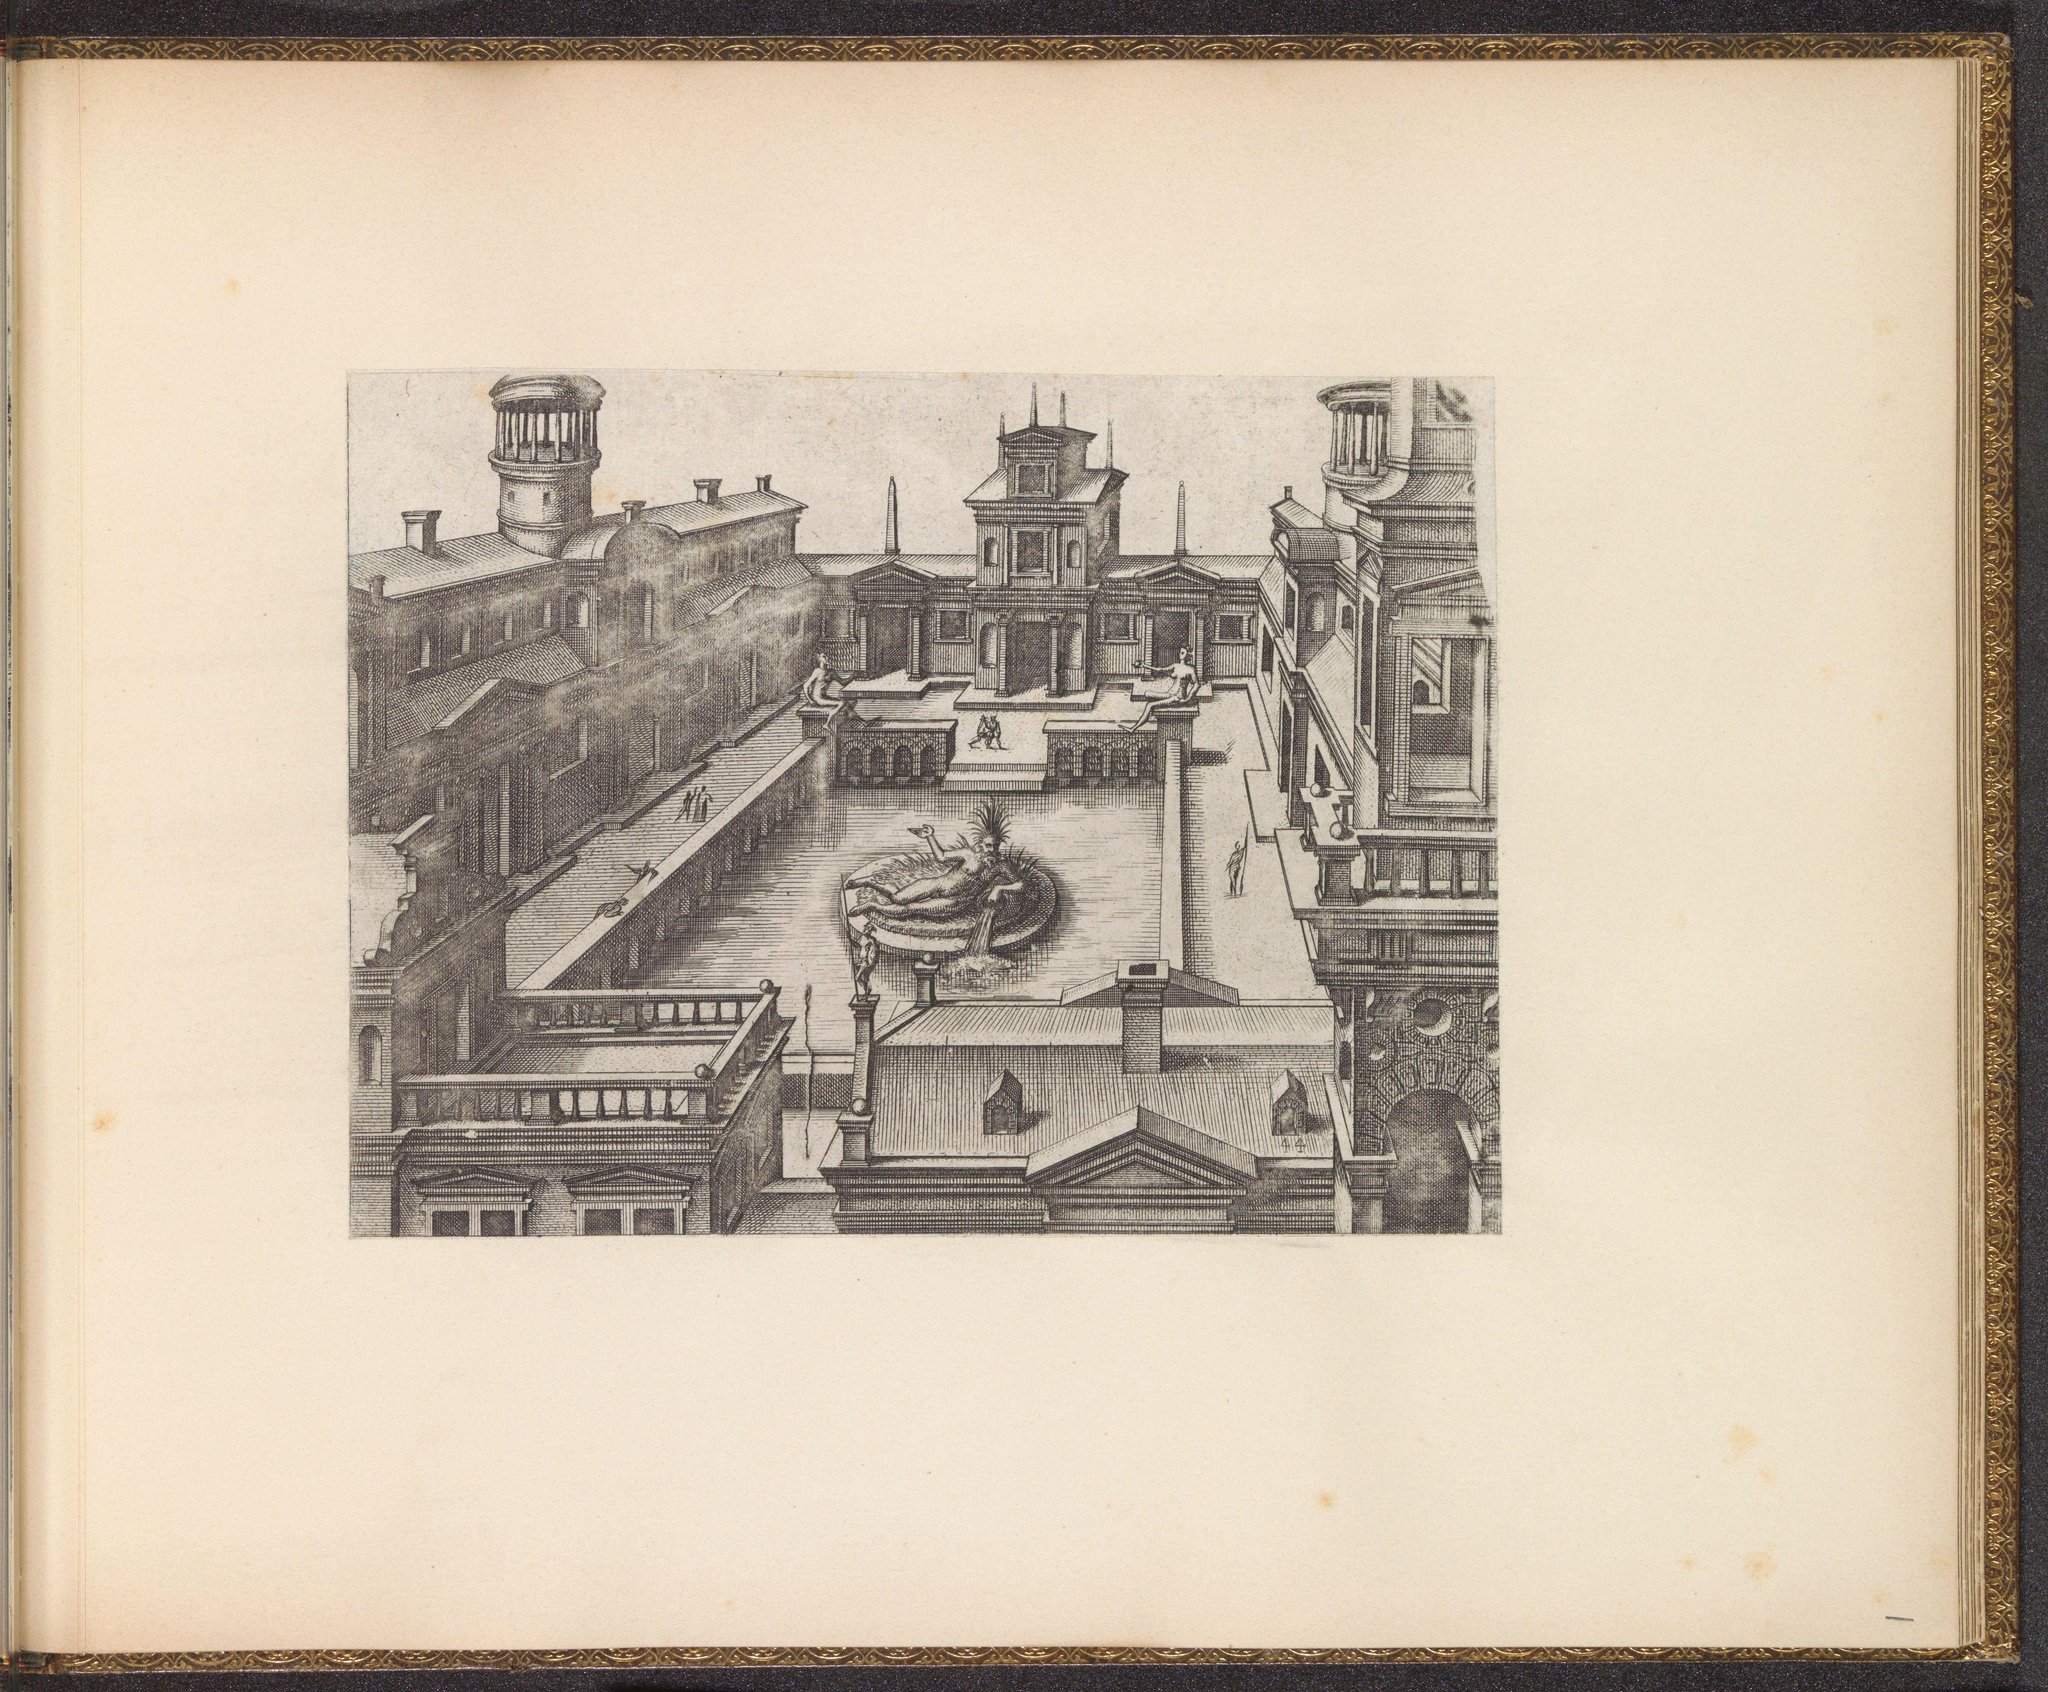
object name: ornament print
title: Architectuurperspectieven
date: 1601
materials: paper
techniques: etching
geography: antwerp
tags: garden fountain, palace, river-gods, inner court of palace or 'hôtel'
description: Binnenplaats van een paleis in semi-vogelvlucht. In het midden ligt een groot waterbassin, omringd door een balustrade. Op een rond eiland in het bassin ligt een riviergod. De prent maakt deel uit van een album.